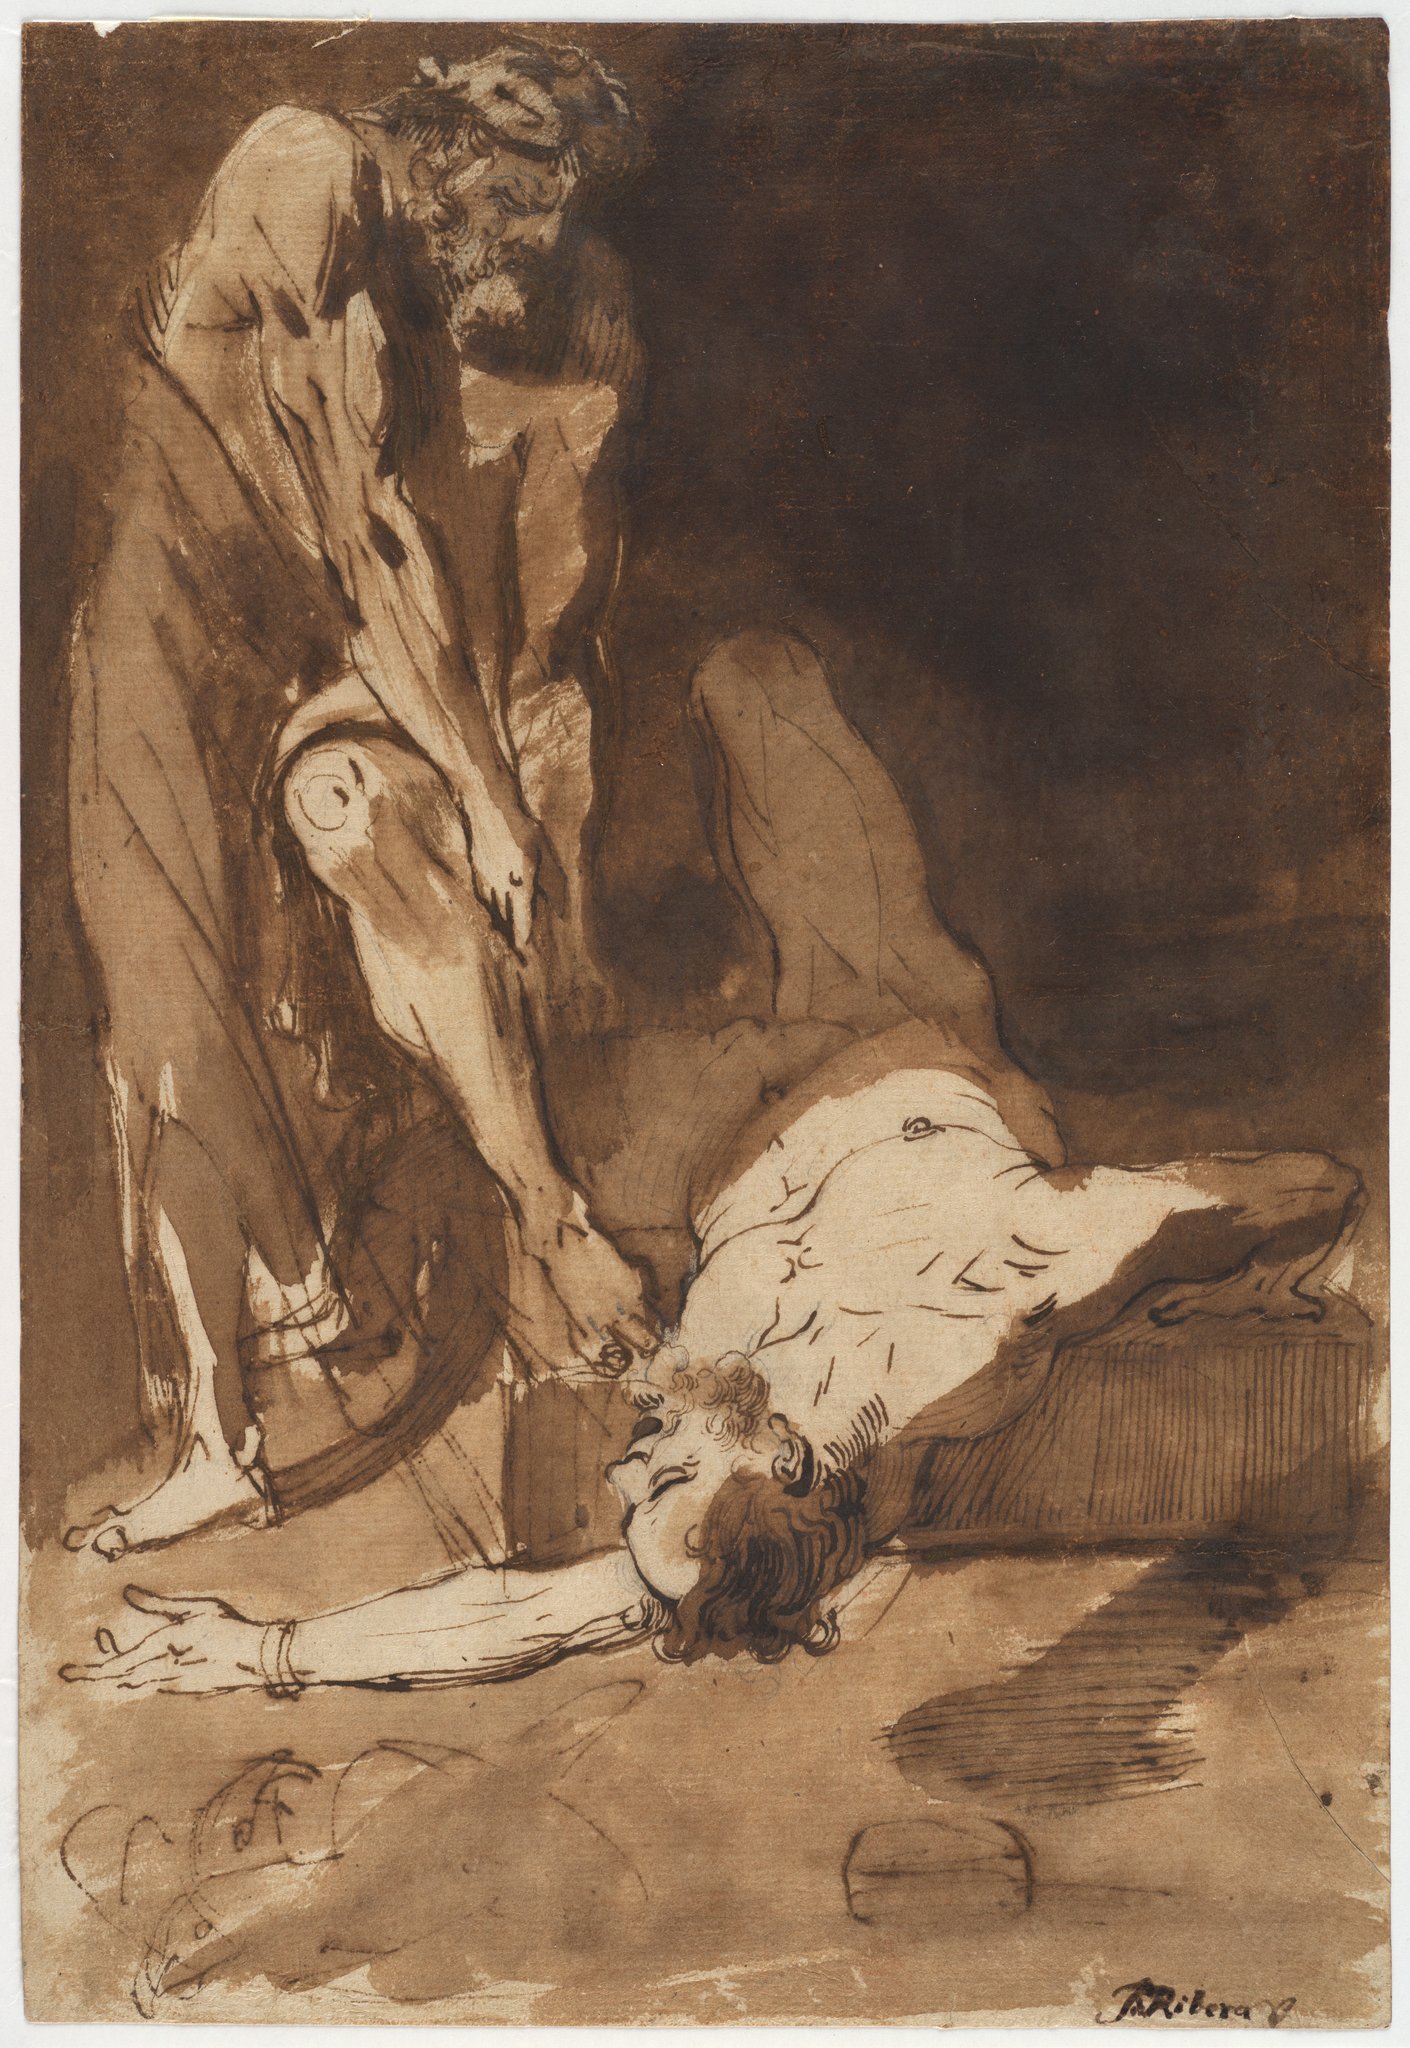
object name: drawing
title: Two Male Nudes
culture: spanish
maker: spanish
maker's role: artist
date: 1701-1800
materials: ink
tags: male nudes